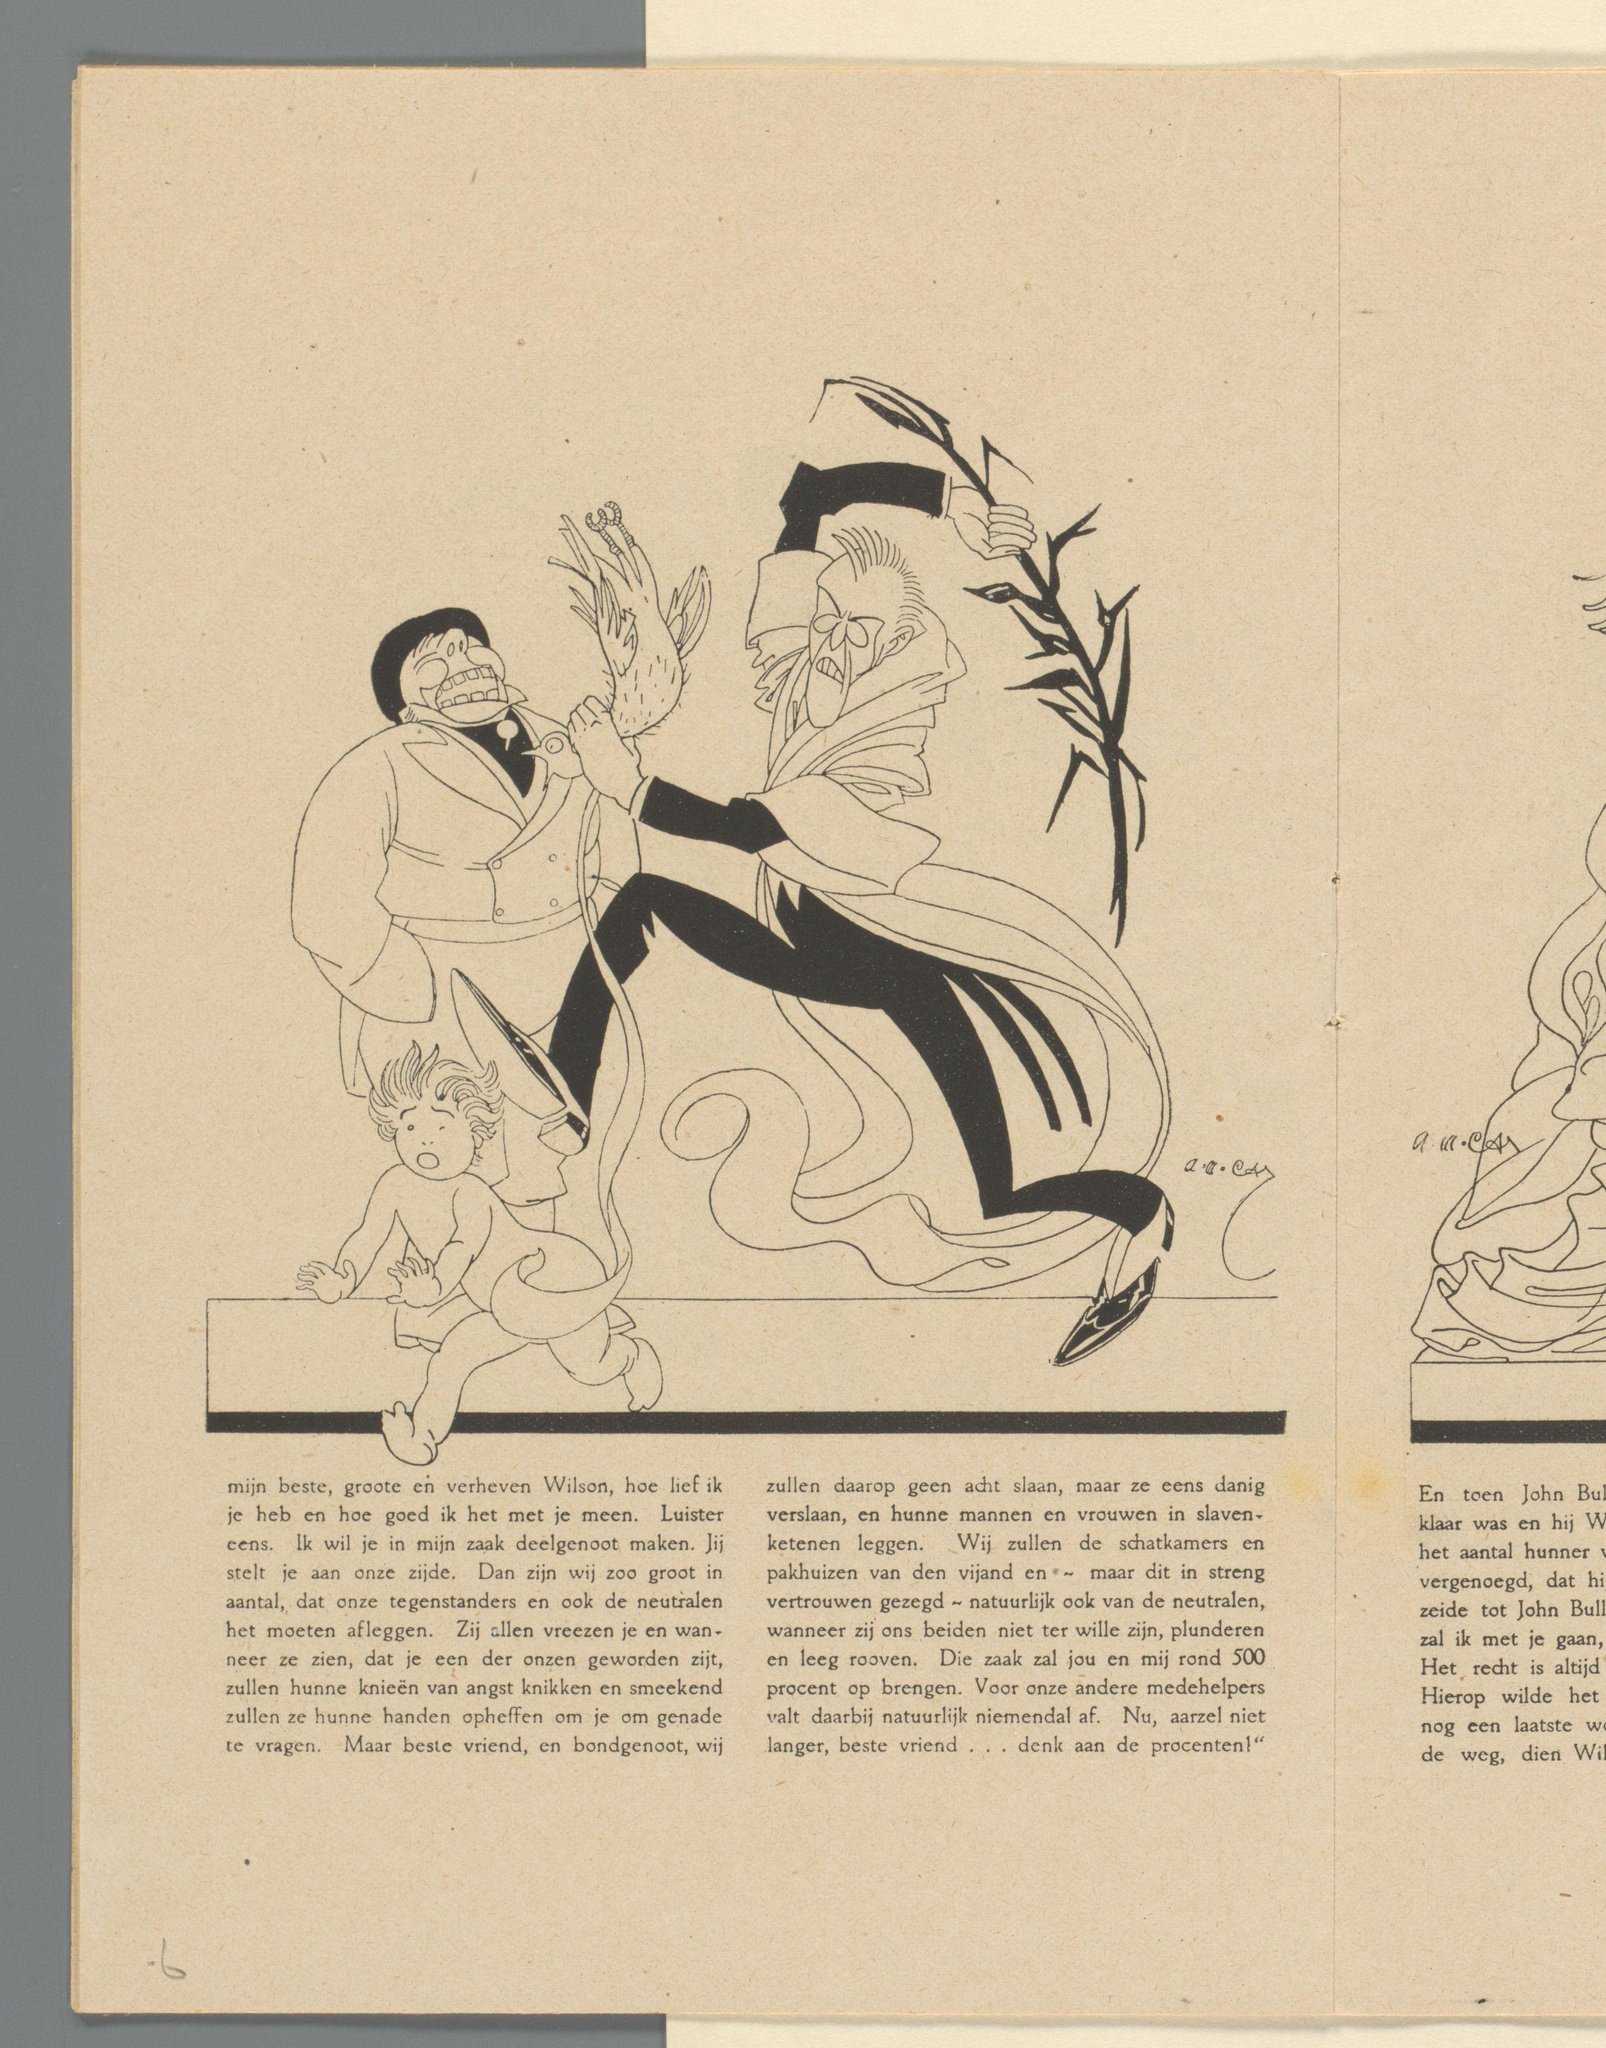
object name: book illustration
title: Terwijl John Bull toekijkt jaagt Woodrow Wilson de vredesengel weg met een geplukte vredesduif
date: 1917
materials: paper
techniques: printing block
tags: president ~ head of republic, political caricatures and satires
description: Prent uit: Cay, A.M. Wilson de menschenvriend; een modern sprookje. S.l.: s.n., ca. 1917.